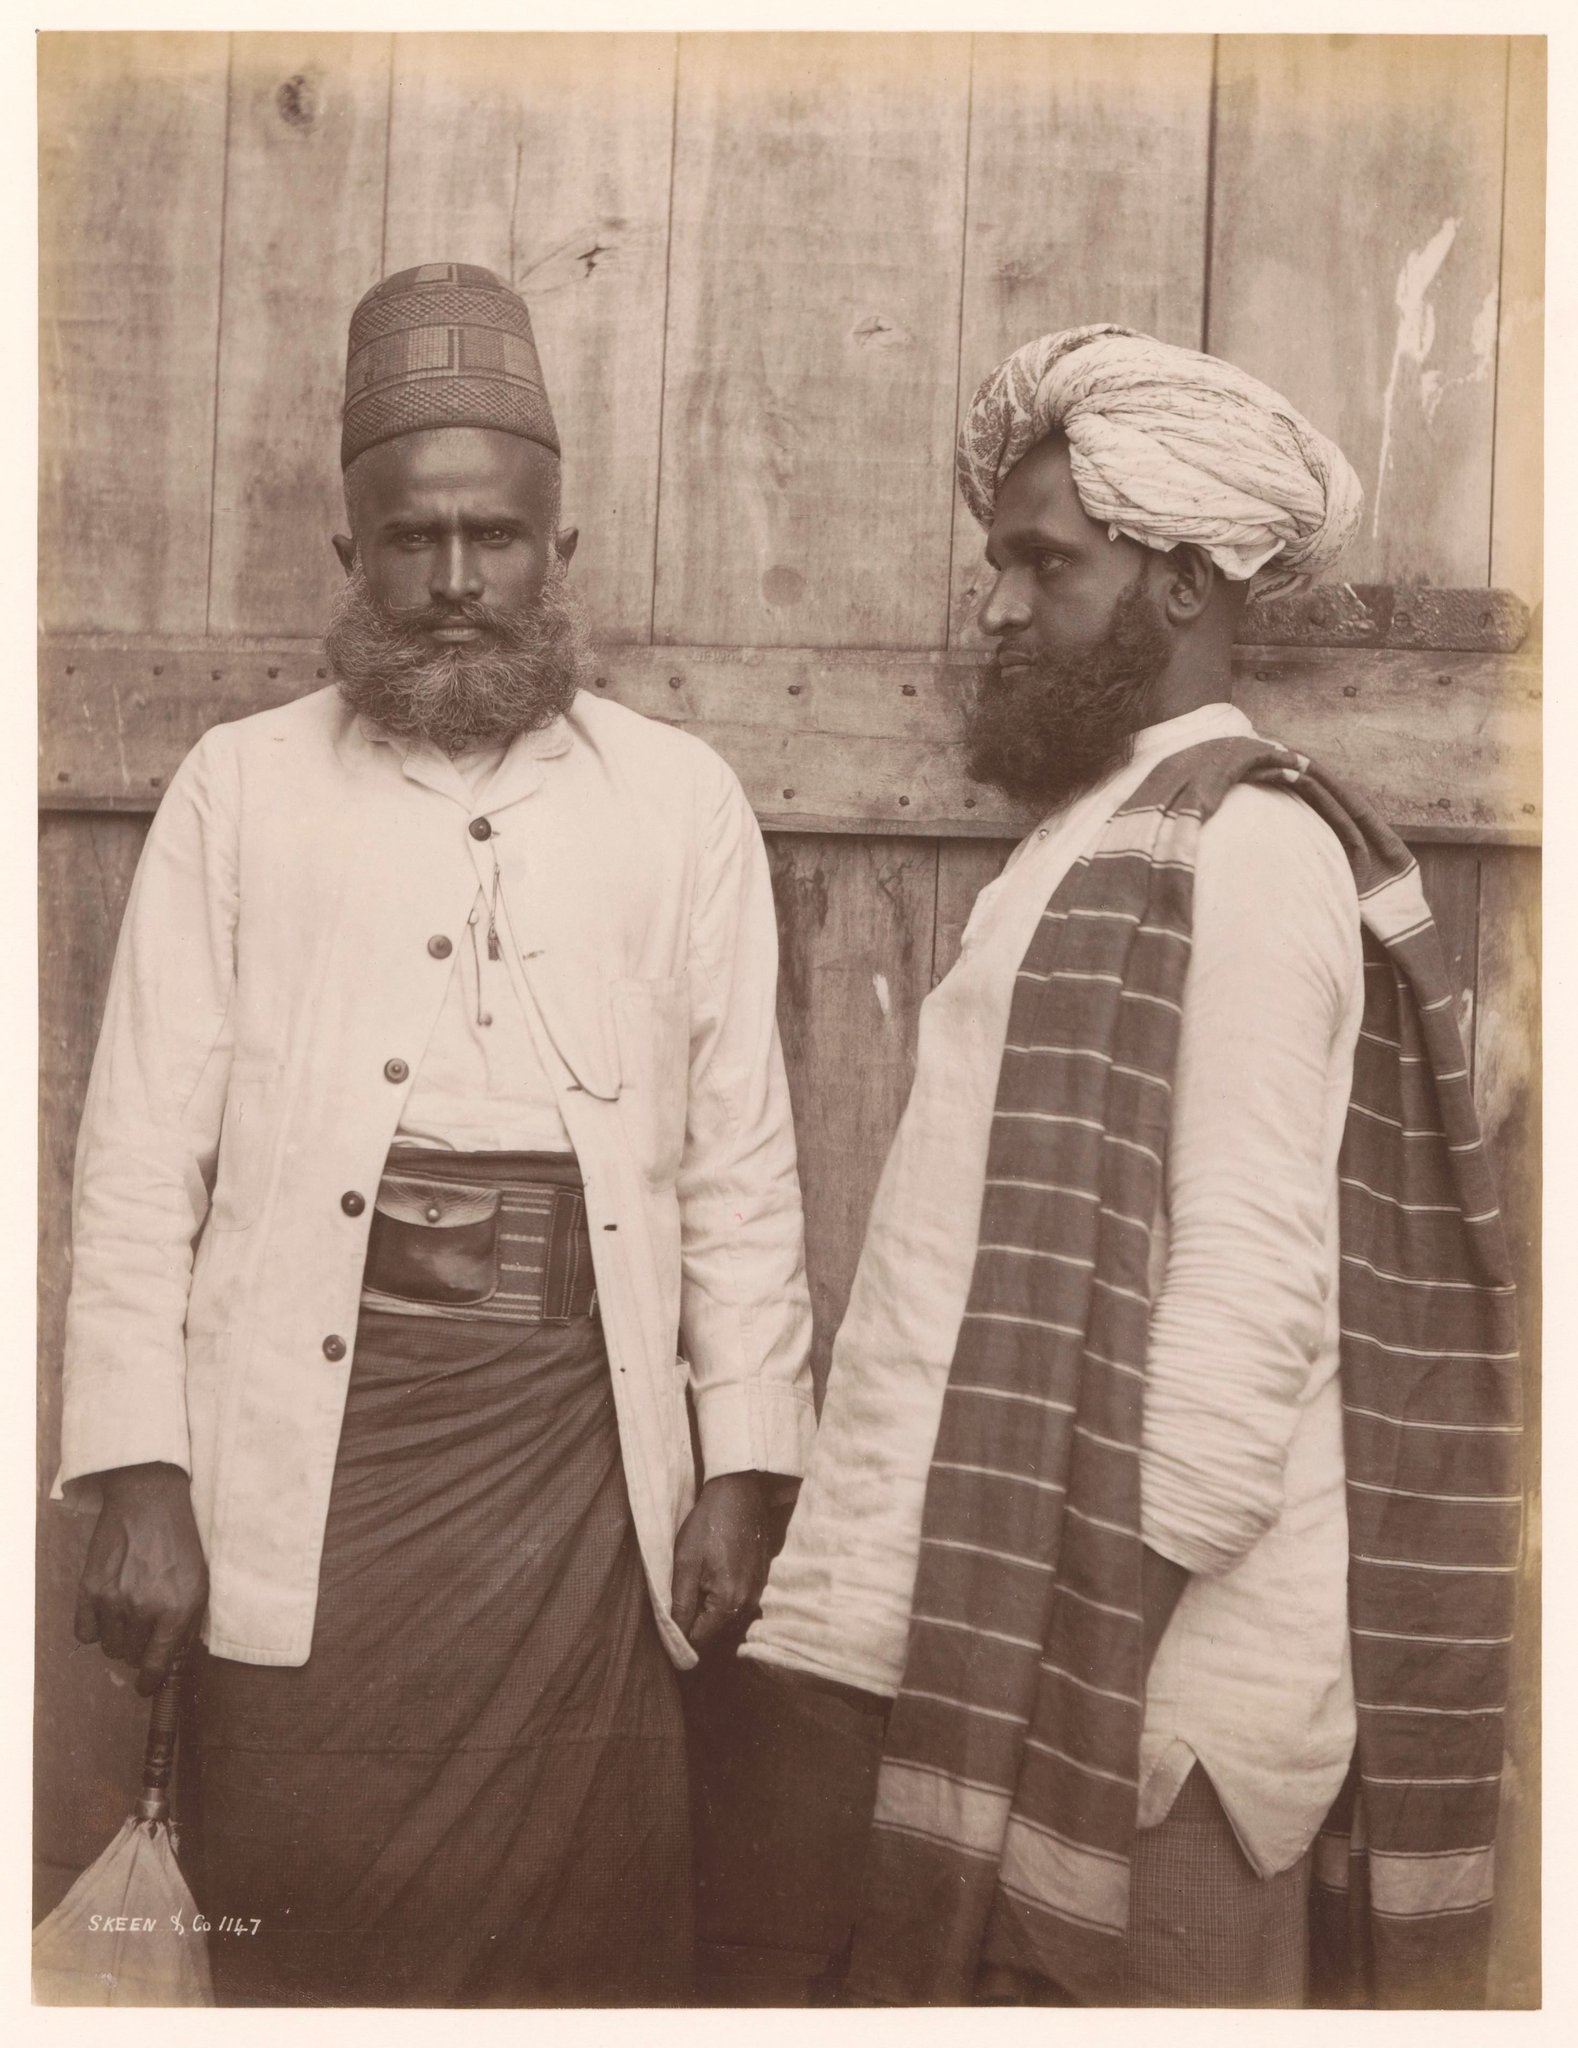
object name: photograph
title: Portrait of two unknown men from the Sri Lankan Moors community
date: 1862-1903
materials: paper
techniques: albumen print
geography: sri lanka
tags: adult man, head-gear: turban, anonymous historical person portrayed, beard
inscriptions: inscription: ‘Skeen & Co. 1147’